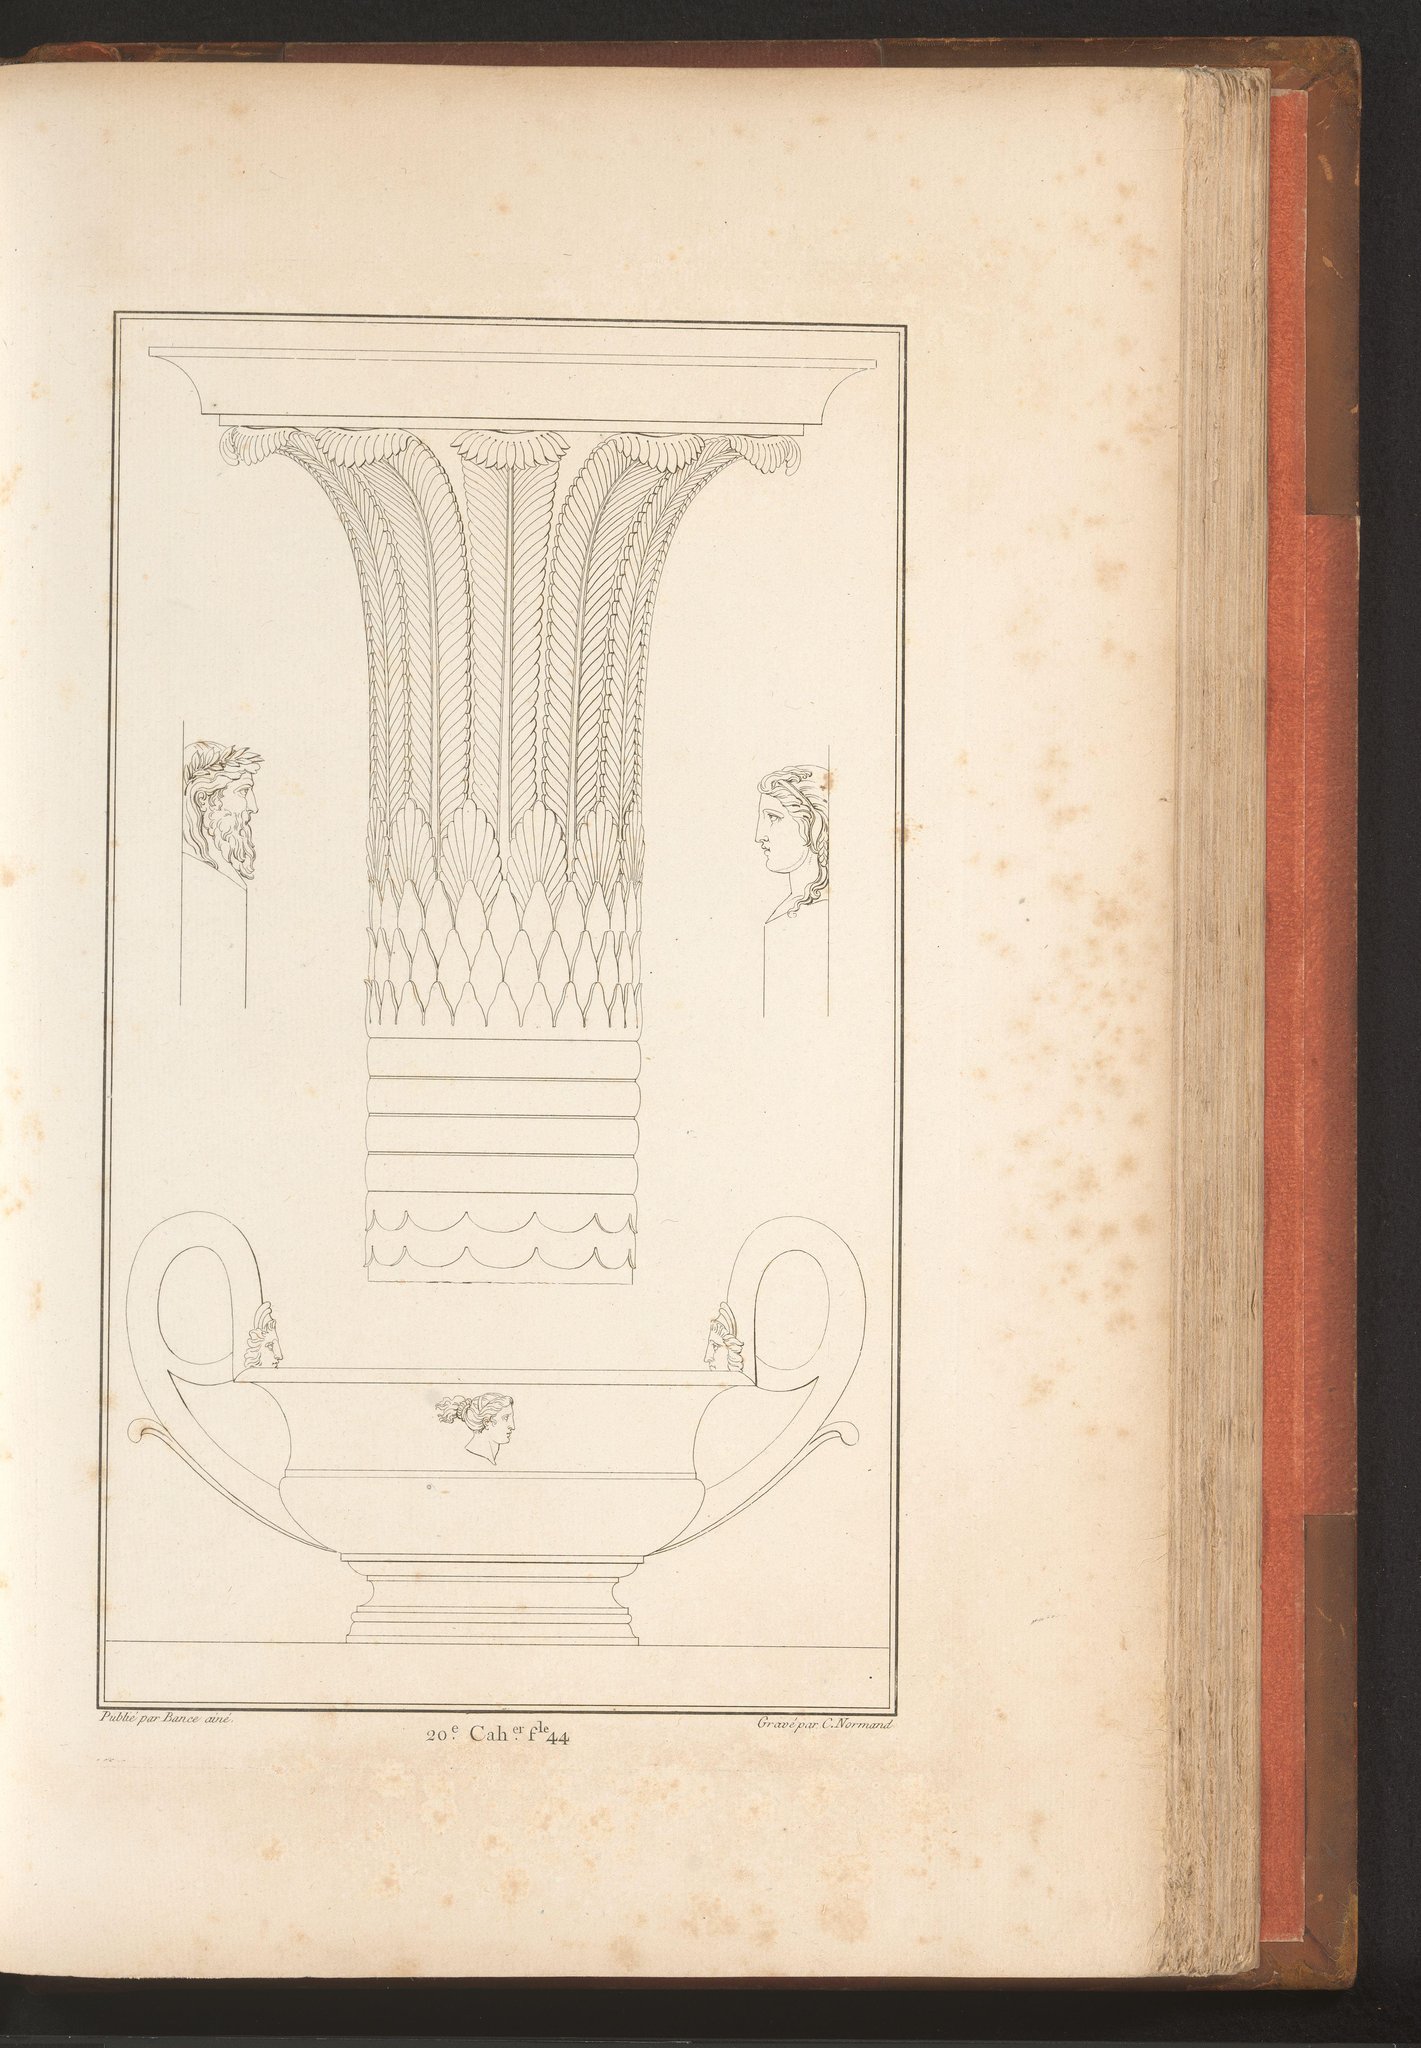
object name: ornament print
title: Zuil en figuren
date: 1820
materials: paper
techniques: etching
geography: paris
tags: ornaments ~ art, capital (~ column, pillar)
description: Ornamentprent met een zuil met kapiteel en enkele figuren. Onderdeel (20e. Cah.er f.le 44) van het prentalbum met twee series van in totaal 138 ornamentprenten door Beauvallet en Normand, 'Fragmens d'Ornemens dans le Style Antique'.